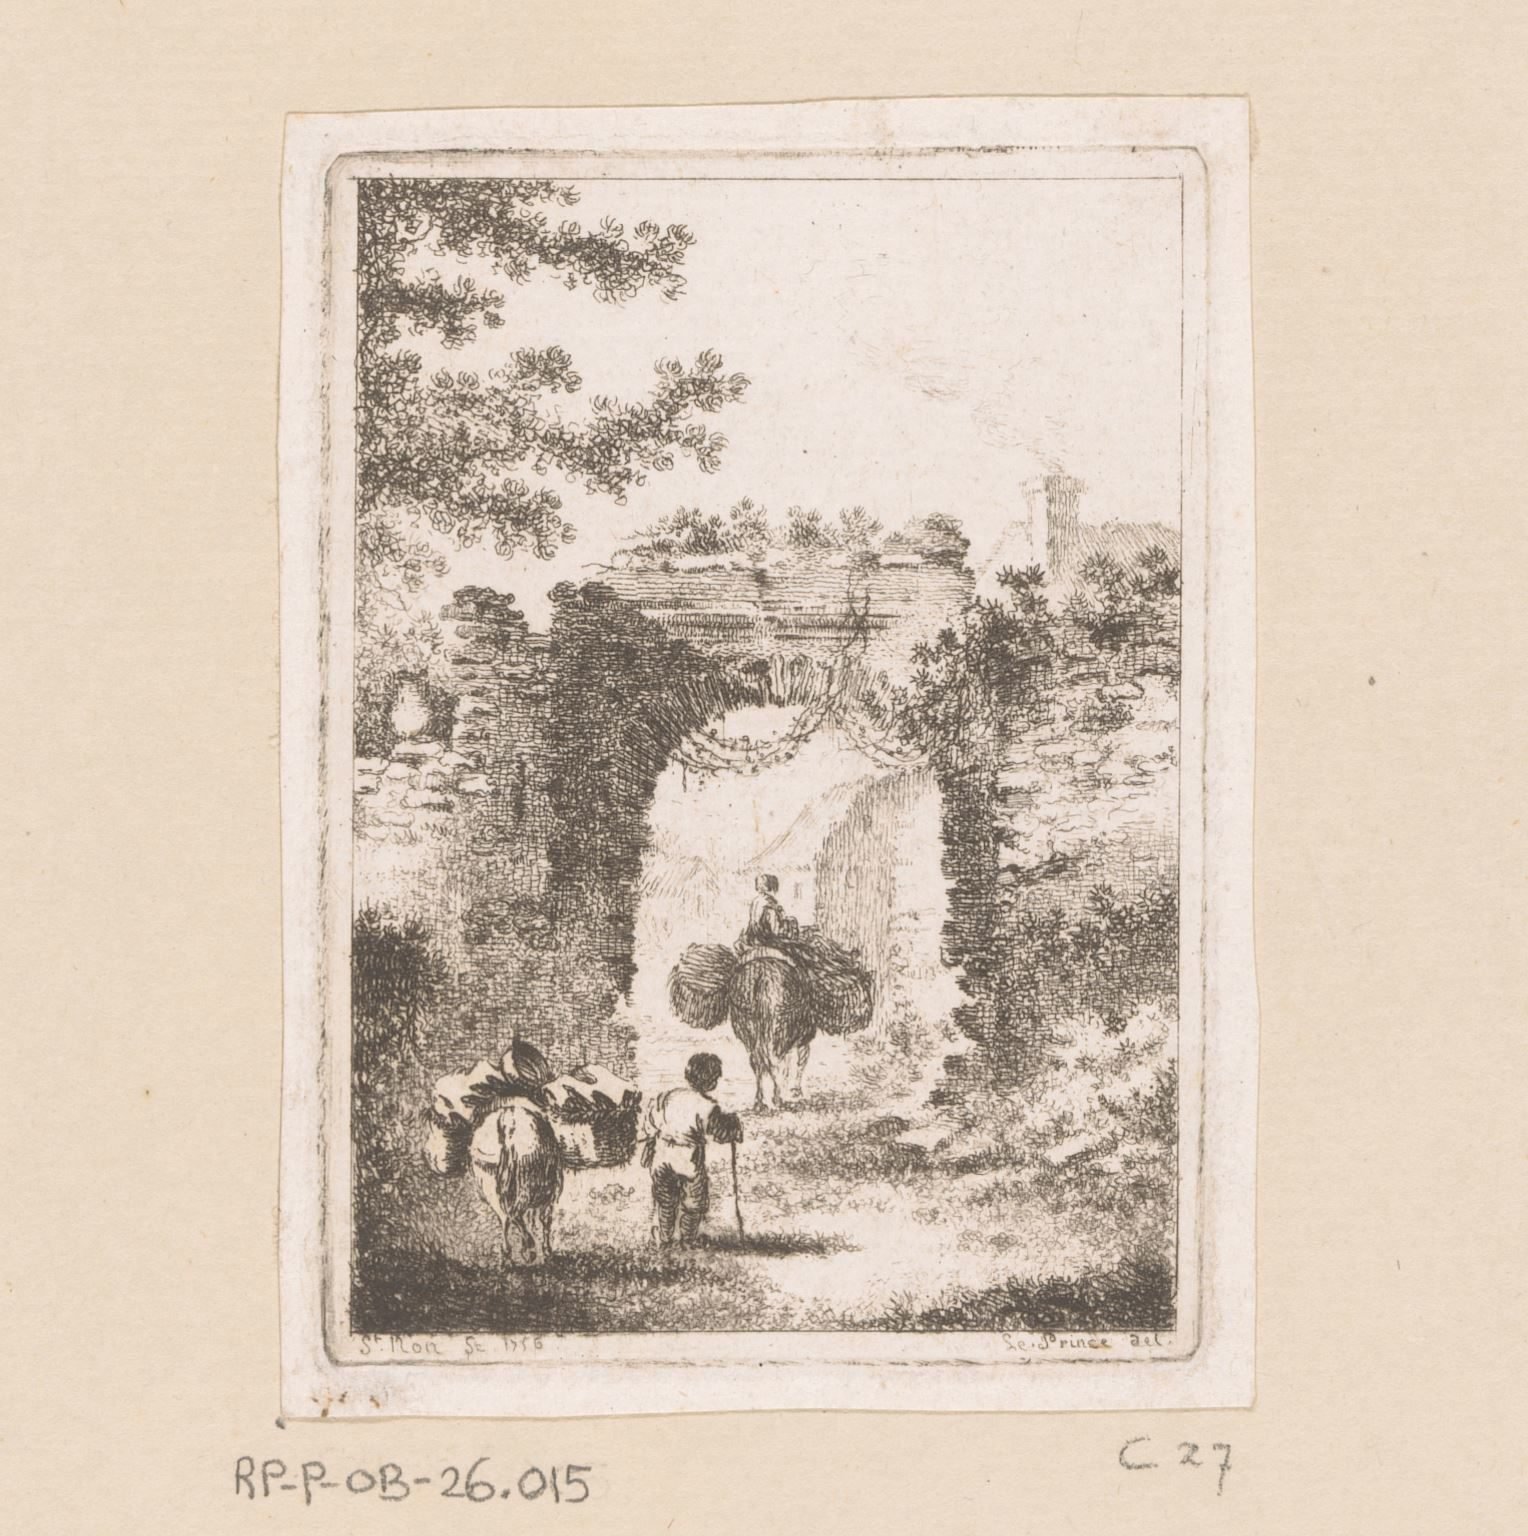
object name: print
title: Gezicht op een weg met oude poort en twee figuren met pakezels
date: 1756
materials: paper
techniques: etching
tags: horses and kindred animals, road, path, village-gate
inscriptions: collector's mark: Lugt 240